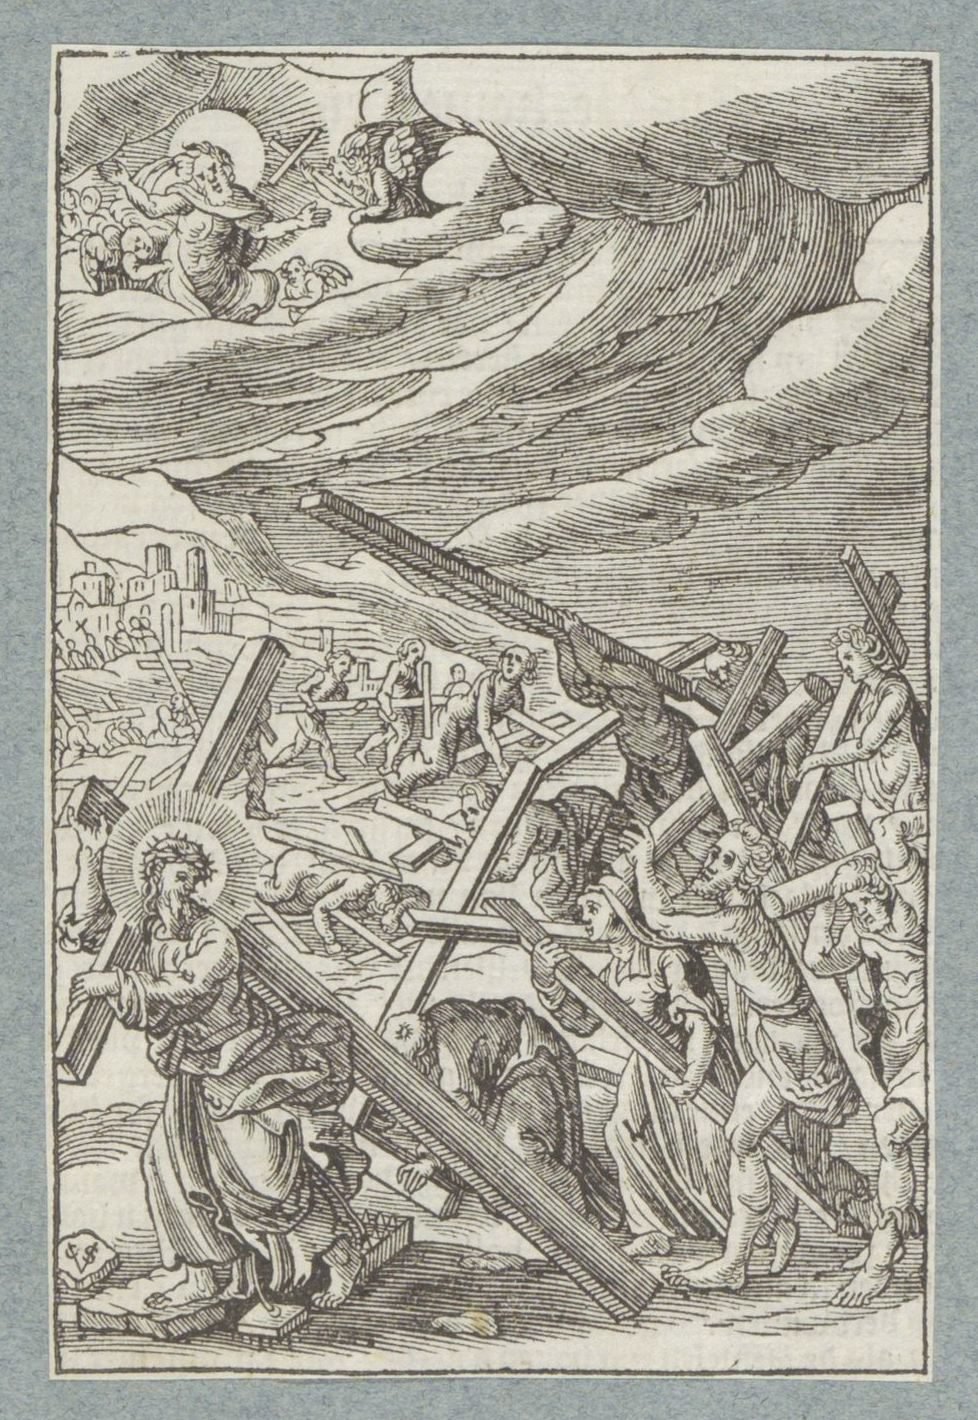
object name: print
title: Laat uw wil gedaan worden op aarde zoals in de hemel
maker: pieter jacobsz. paets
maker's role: publisher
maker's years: 1587-1667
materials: paper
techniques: letterpress printing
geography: amsterdam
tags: god the father, 'thy will be done on earth, as it is in heaven' ~ the lord's prayer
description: De prent is afkomstig uit een van de uitgaven van P.J. Paets uit Amsterdam. Ze komt in ieder geval voor in: Het Nieuwe Testament ons Salichmaeckers Jesu Christi. Amsterdam, P.J. Paets, 1646. De voorstelling is gekopieerd naar een prent van Johannes Wierix naar ontwerp van Maarten van Heemskerck, onderdeel van een serie van acht prenten over het Onze Vader.